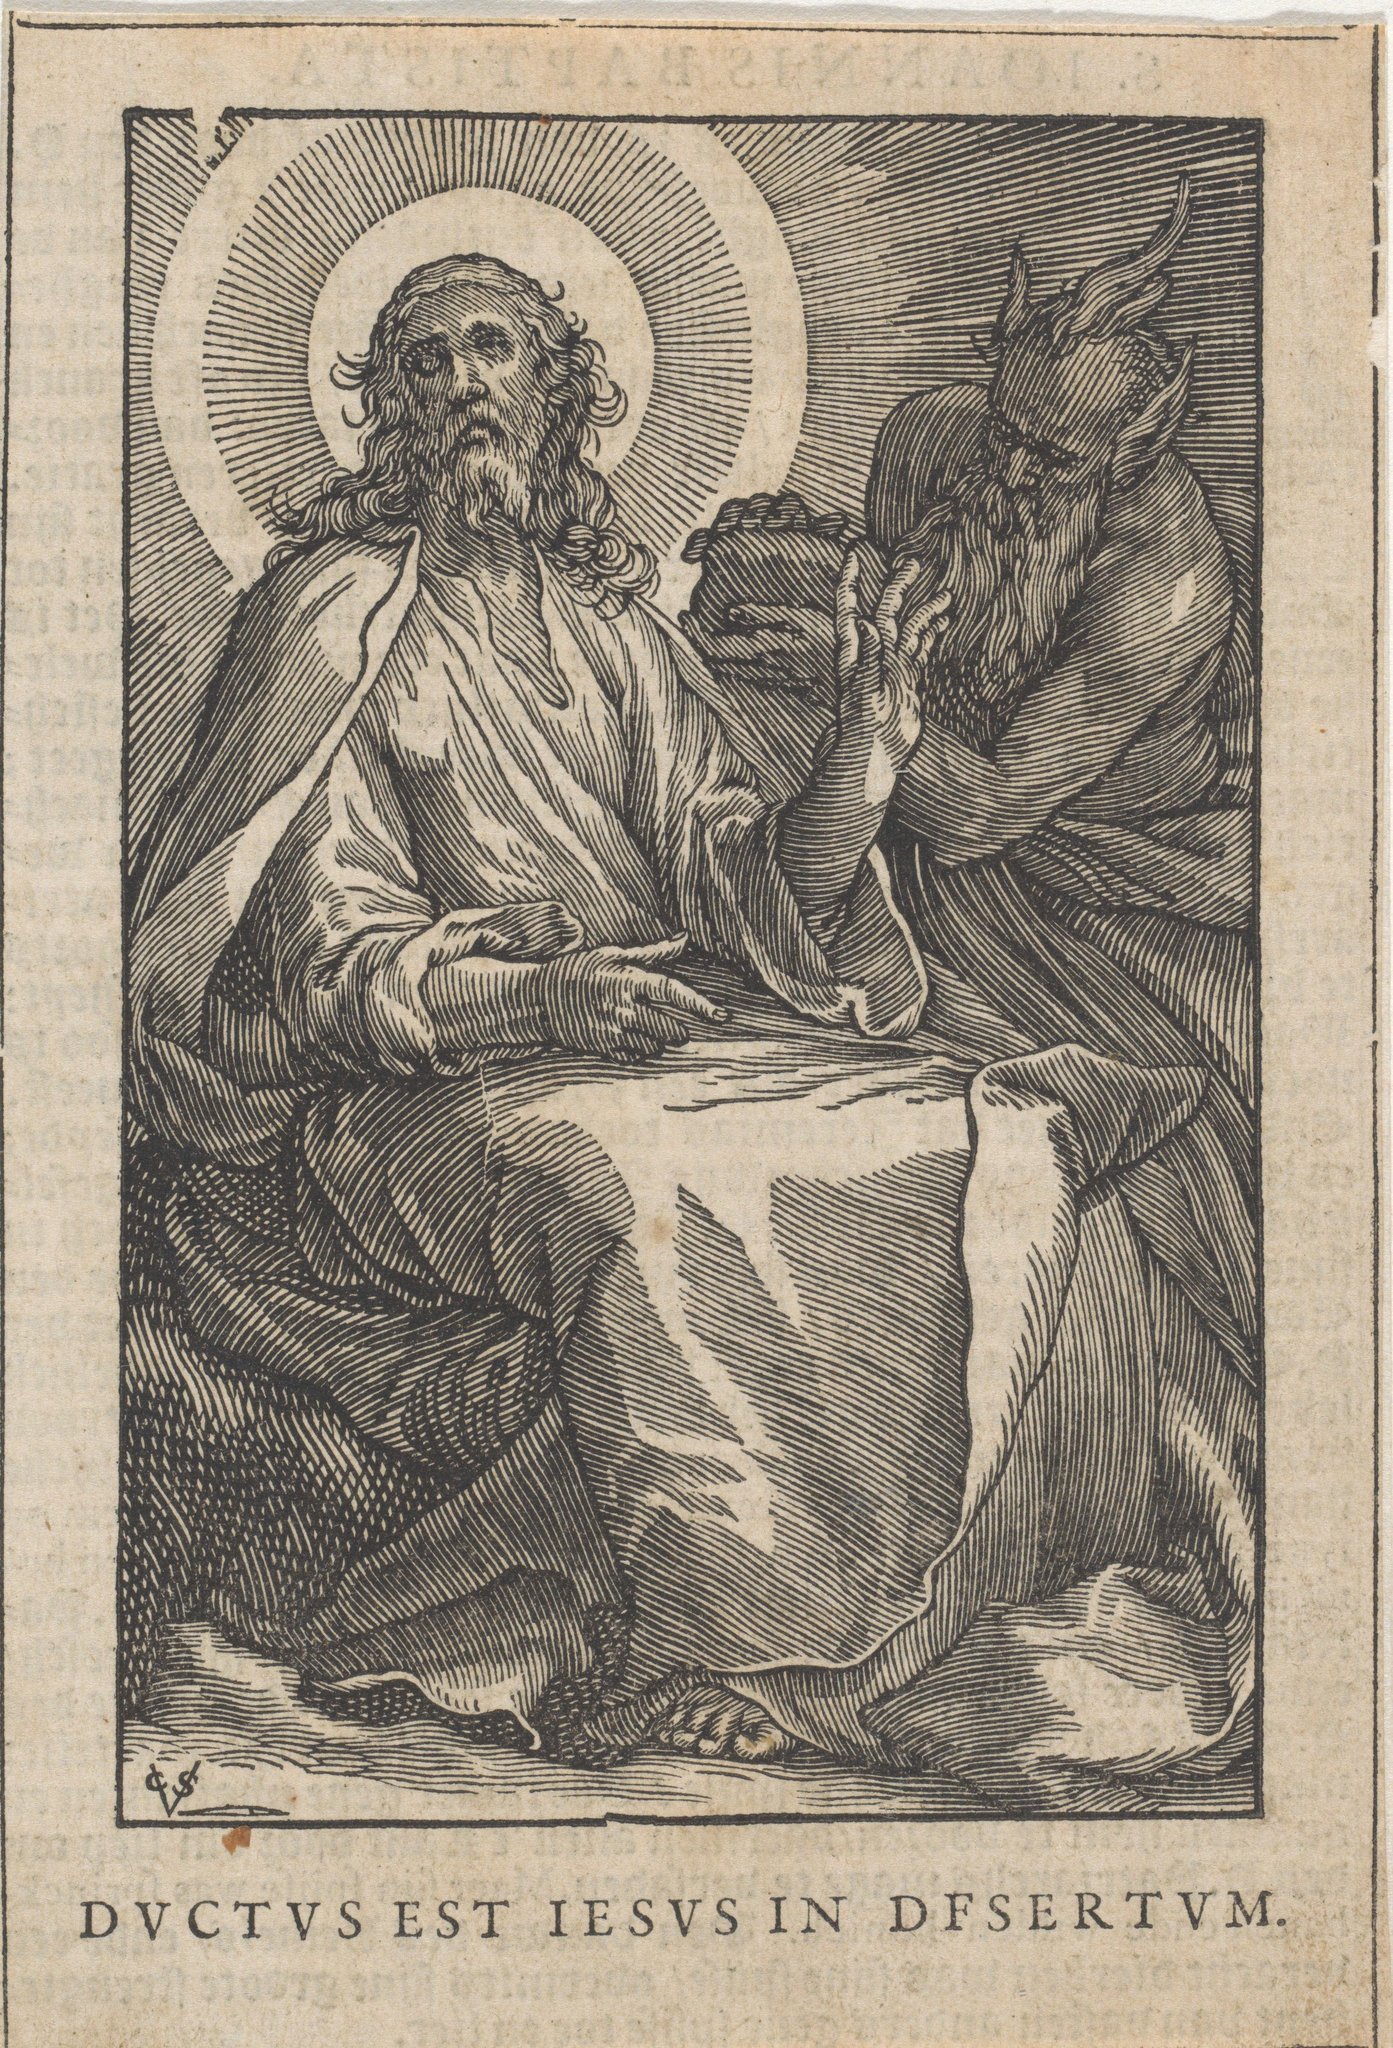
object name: print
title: Ductus est Iesus in desertum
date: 1644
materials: paper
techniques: letterpress printing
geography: amsterdam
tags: 'command these stones to become loaves of bread' ~ temptation of christ in the wilderness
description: Prent uit: Rosweyde, Heribert. 'tBosch der eremyten ende eremitinnen, van Aegypten ende Palestinen. Amsterdam: Pieter Jacobsz. Paets, 1644.